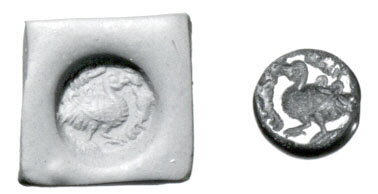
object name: stamp seal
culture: sasanian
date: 401-600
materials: gemstone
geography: iran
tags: birds